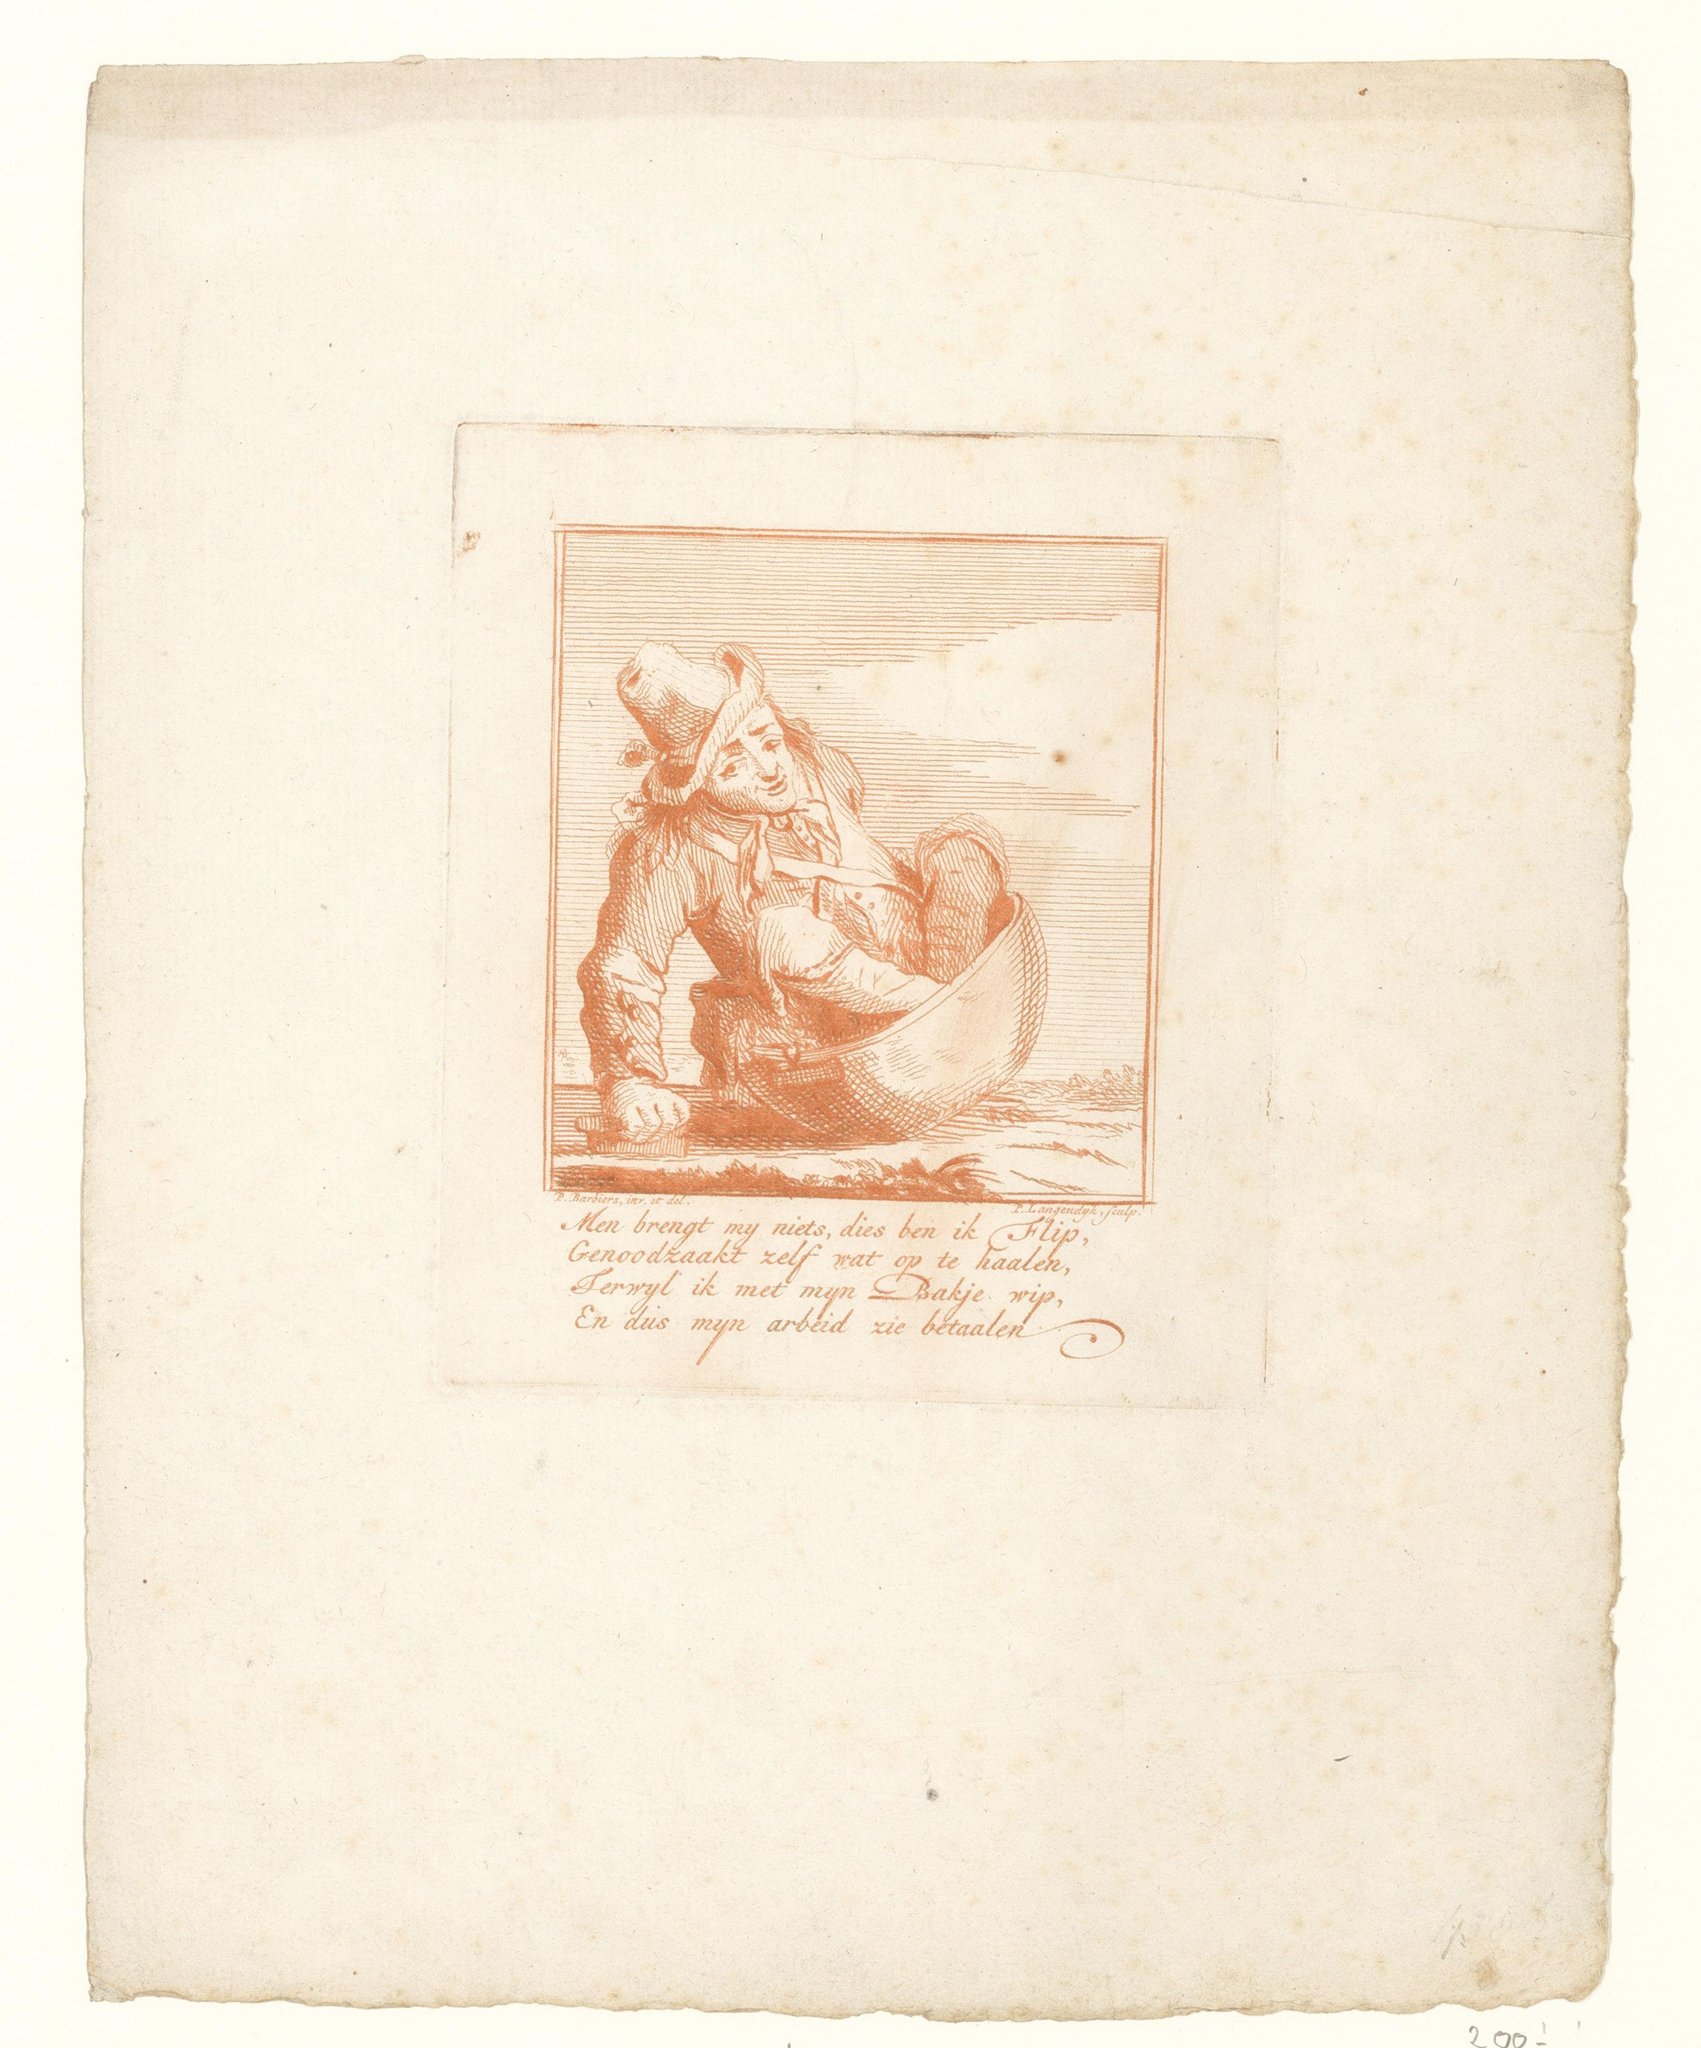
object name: print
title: Amsterdamse straatfiguren rond 1770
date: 1770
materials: paper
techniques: engraving, etching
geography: netherlands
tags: person with a physical disability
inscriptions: collector's mark, collector's mark: Lugt 1641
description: Een kreupele man beweegt zich voort in een rond bakje. In de marge een vierregelig vers in het Nederlands. Onderdeel van een serie van prenten van Amsterdamse straatfiguren rond 1770. Onderwerpsrubrieken binnen de Atlas Zeden en Gewoonten: Mannelijk beroep en bedrijf: Marskramers, straatventers, straatslijpers, bedelaars, straatvertooningen enz.